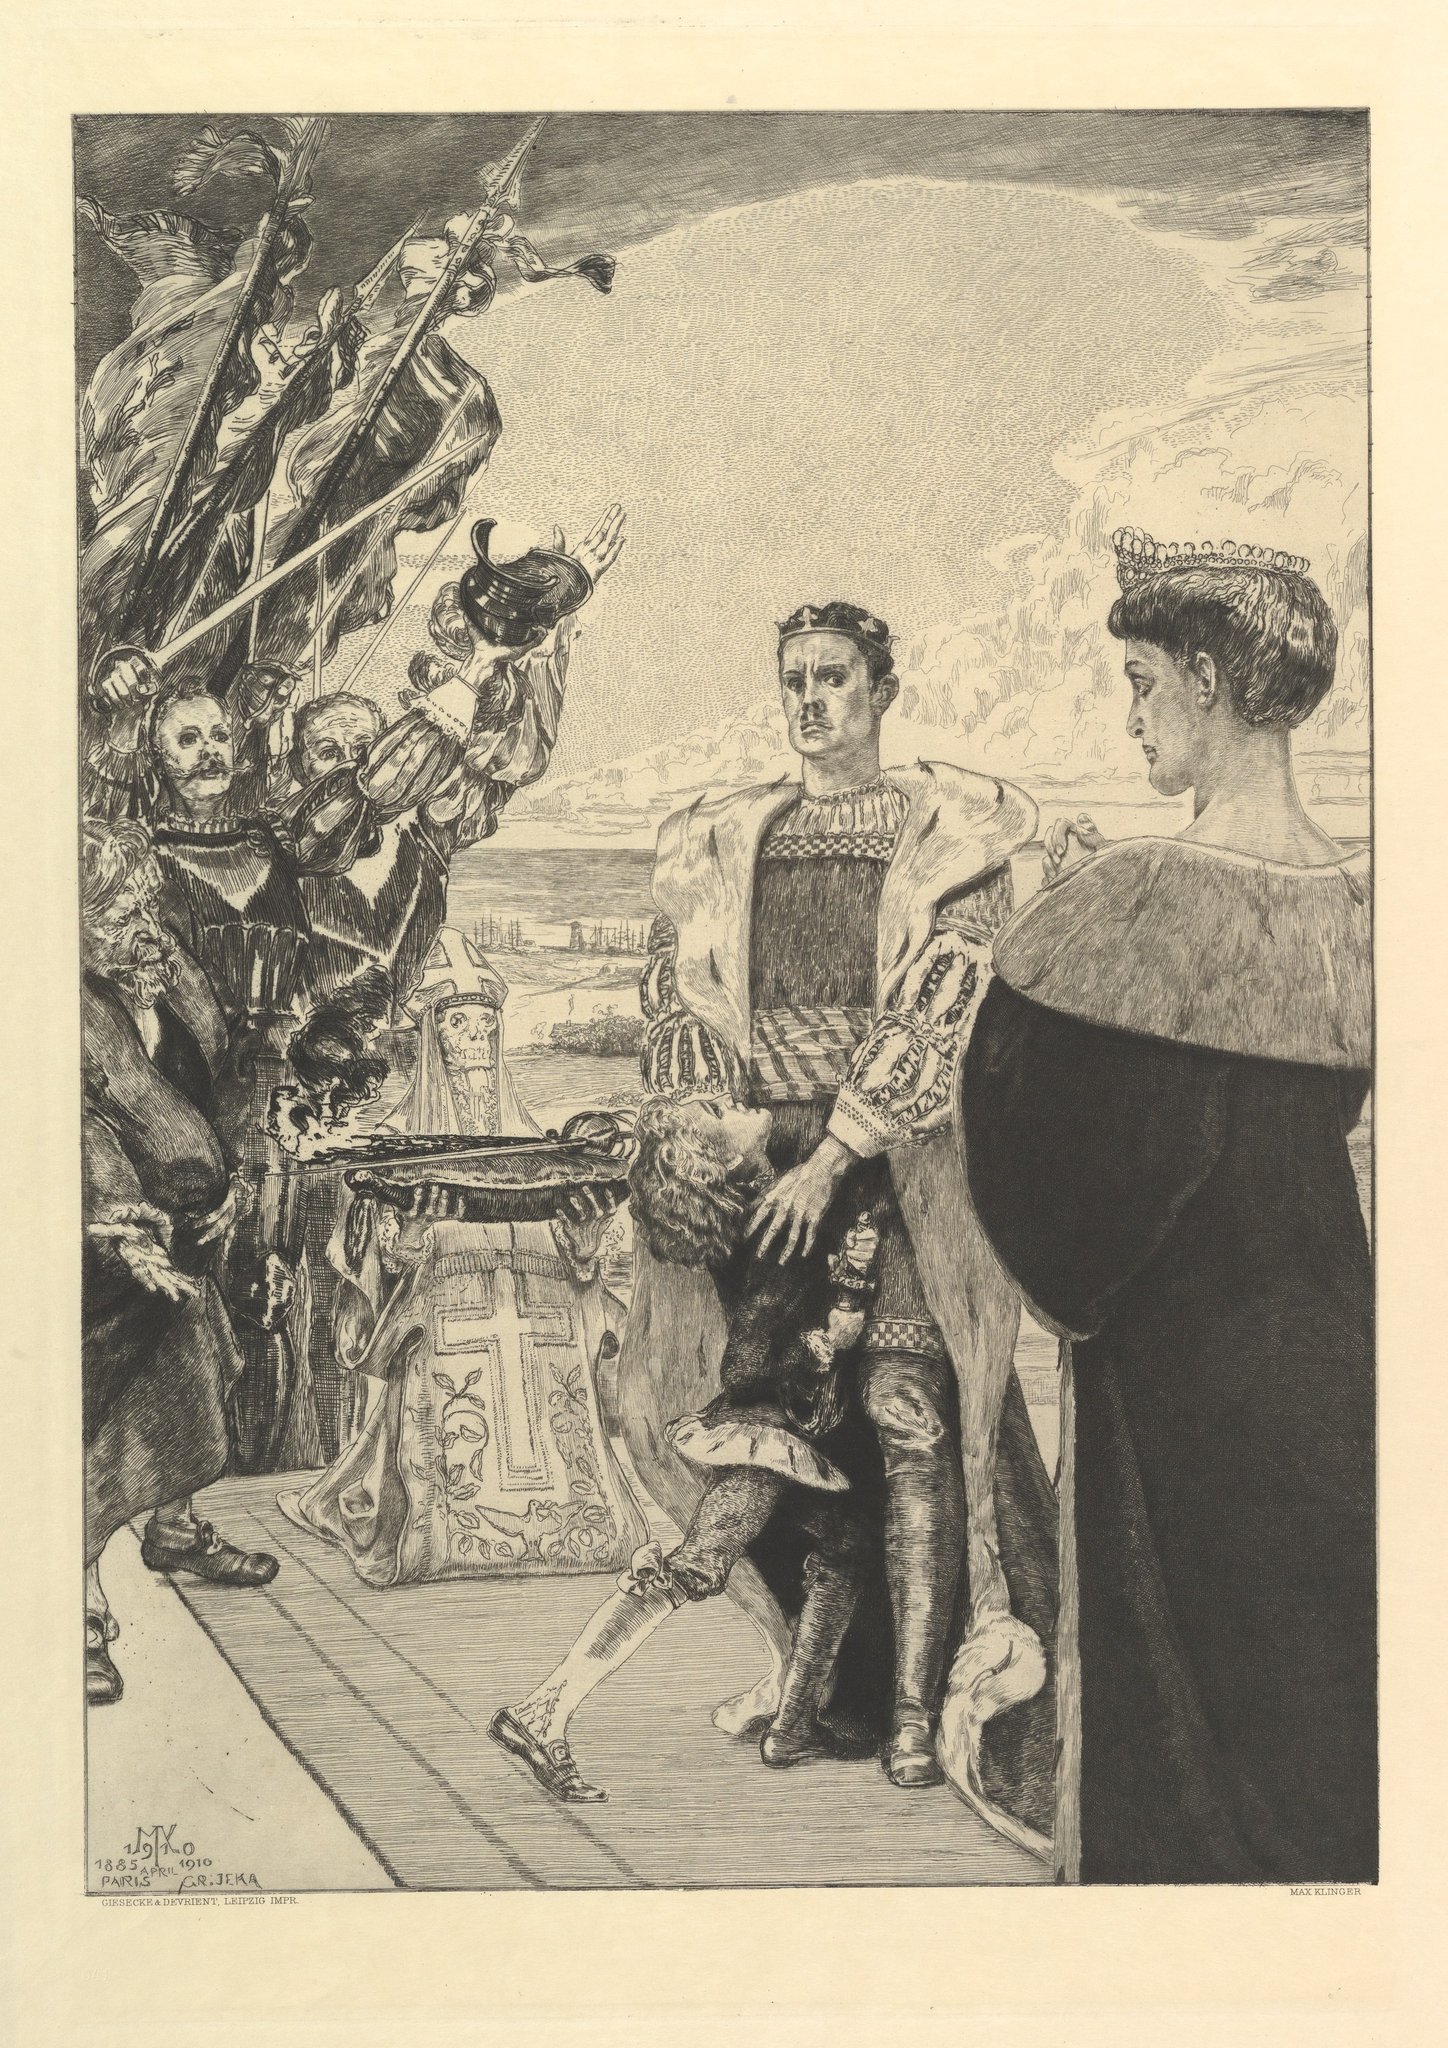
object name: print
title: Herrscher, from the series Vom Tode Zweiter Teil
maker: max klinger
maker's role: artist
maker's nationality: german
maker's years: 1857-1920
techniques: etching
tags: swords,children,men,women